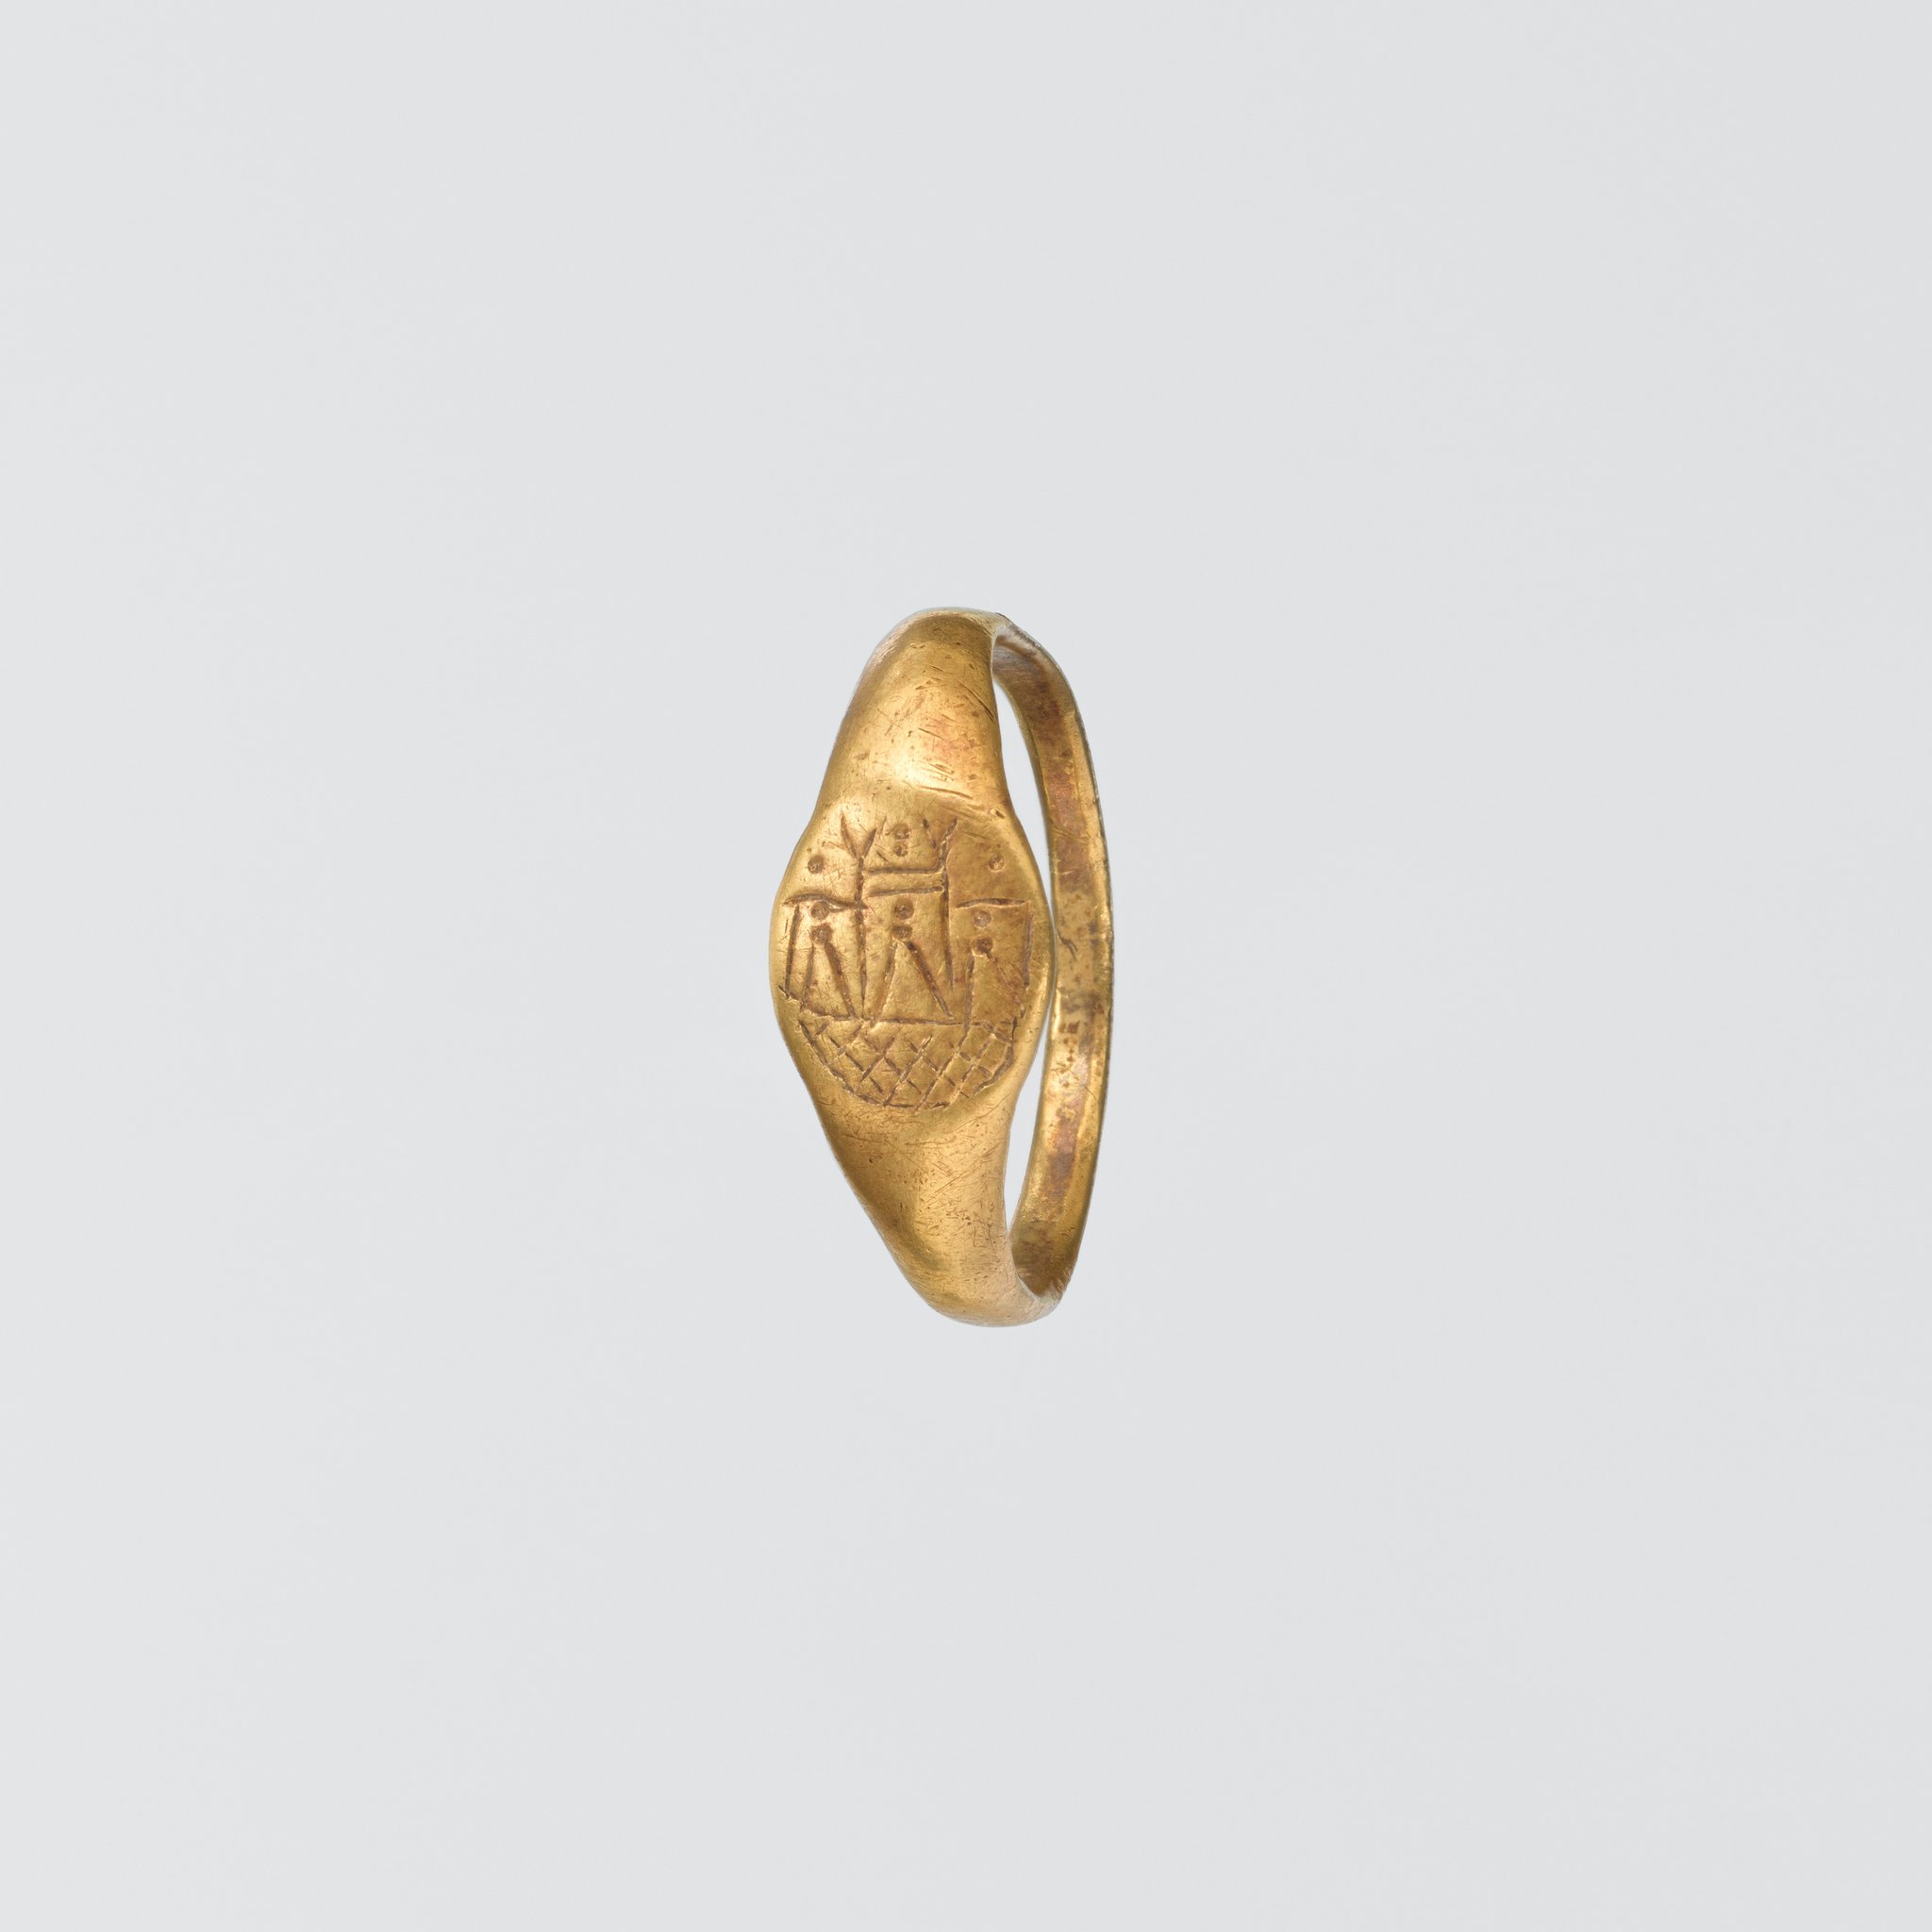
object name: ring with sanctuary of aphrodite at palaepaphos engraved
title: Gold ring with representation of the temple of Aphrodite at Paphos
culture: roman, cypriot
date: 1-200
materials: gold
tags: temples